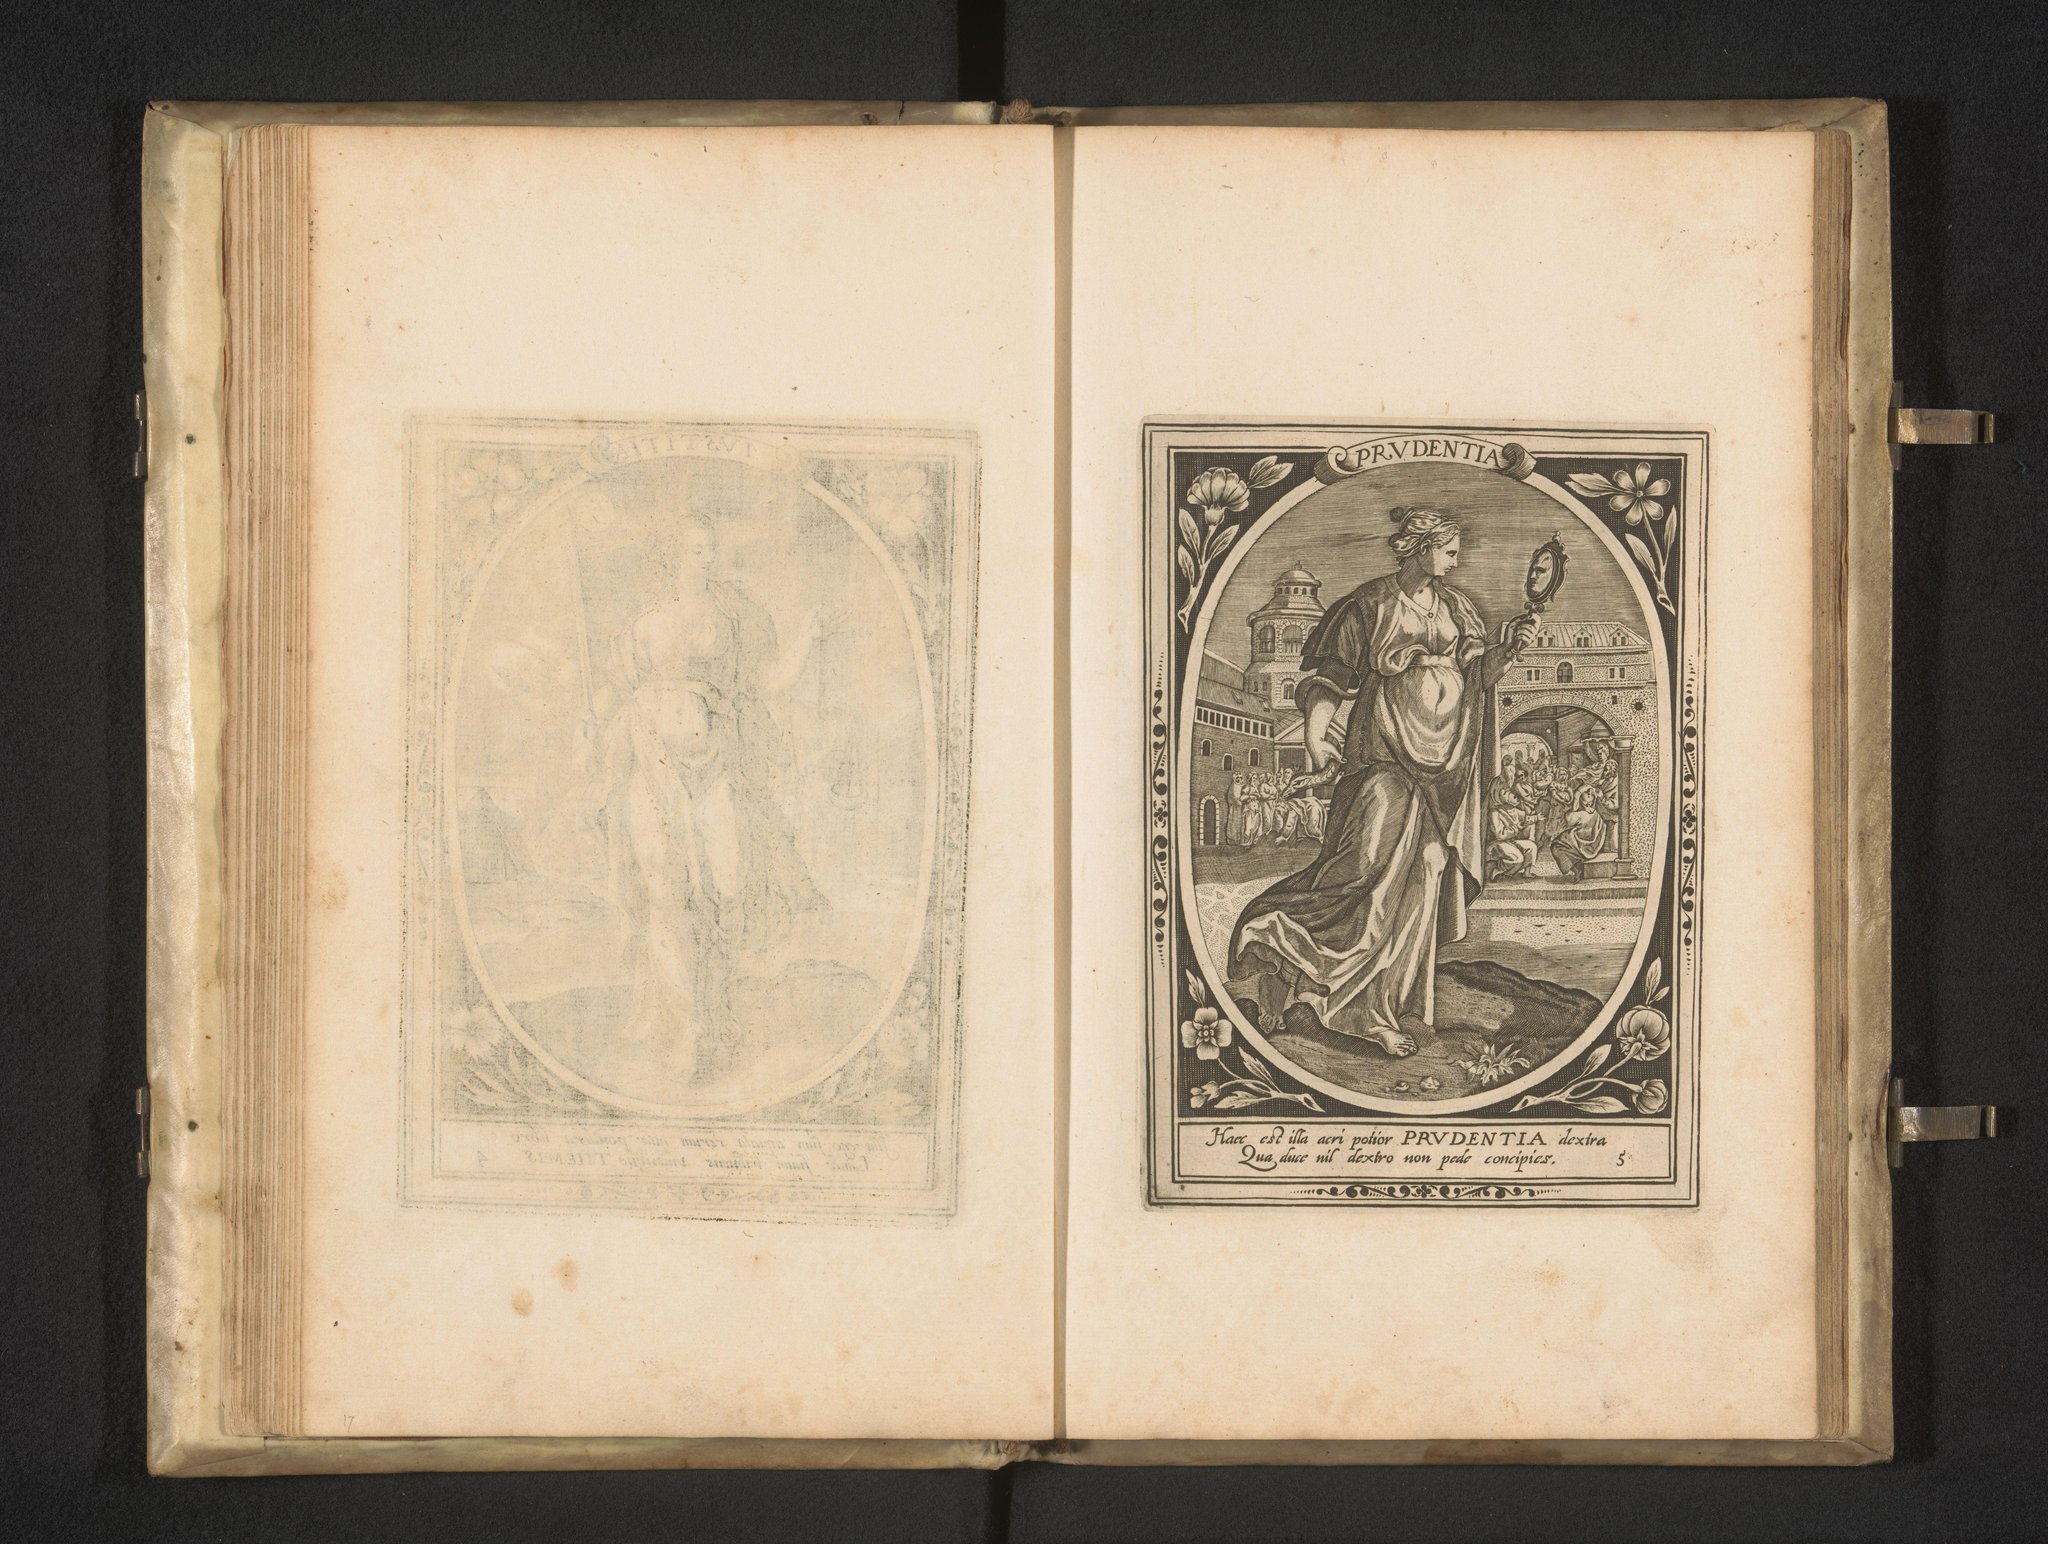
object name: print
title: Zeven theologische en kardinale deugden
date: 1600-1670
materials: paper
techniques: engraving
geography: antwerp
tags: prudence, 'prudentia'; 'prudenza' (ripa) ~ one of the four cardinal virtues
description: De Voorzichtigheid (Prudentia). Genummered rechtsonder: 5. Onderdeel van de serie van zeven theologische en kardinale deugden. Onderdeel van een album met voornamelijk christelijke voorstellingen.